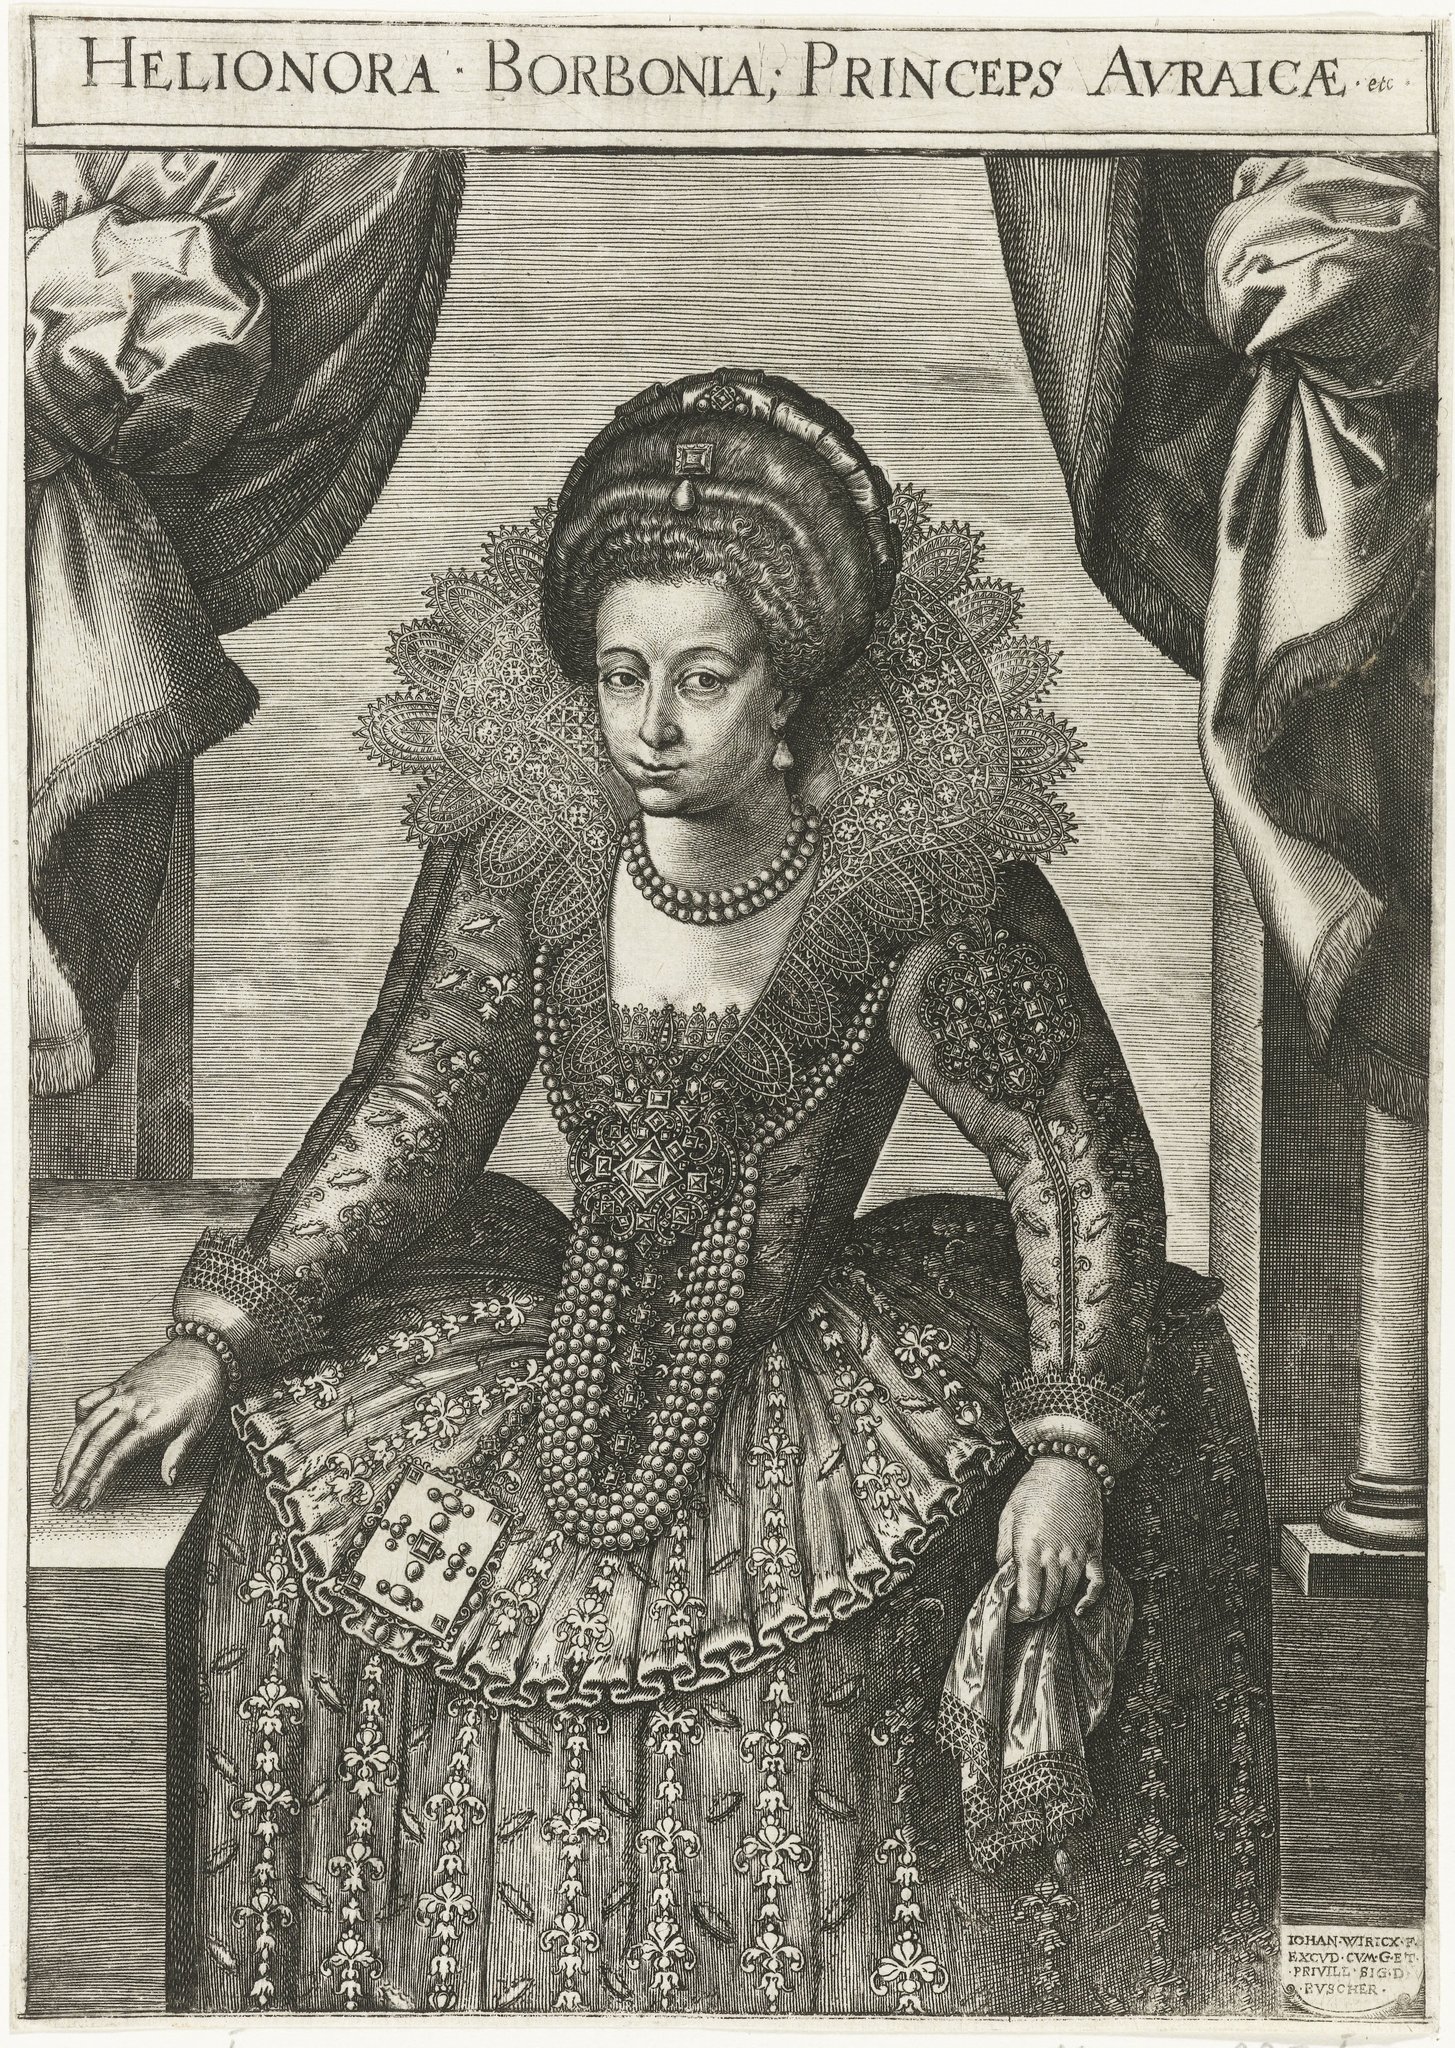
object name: print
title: Helionora Borbonia Princeps Avraicæ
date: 1600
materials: paper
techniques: engraving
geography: antwerp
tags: éléonore de bourbon, ear-rings (+ women's clothes), handkerchief (+ women's clothes), dress, gown (fartingale) (+ women's clothes), neck-gear: collar (+ women's clothes), clothes, costume (+ women's clothes), hairdress - aa - ~ women, sleeves: cuffs (+ women's clothes), sleeves (+ women's clothes), clothing for the upper part of the body (with name) (+ women's clothes), pearl; pearl necklace (+ women's clothes)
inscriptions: collector's mark: Lugt 240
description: Eleonora van Bourbon, in een rijk geborduurde japon met fardegalijn; opstaande kanten kraag, dubbel parelsnoer om de hals. In de hand een zakdoek.